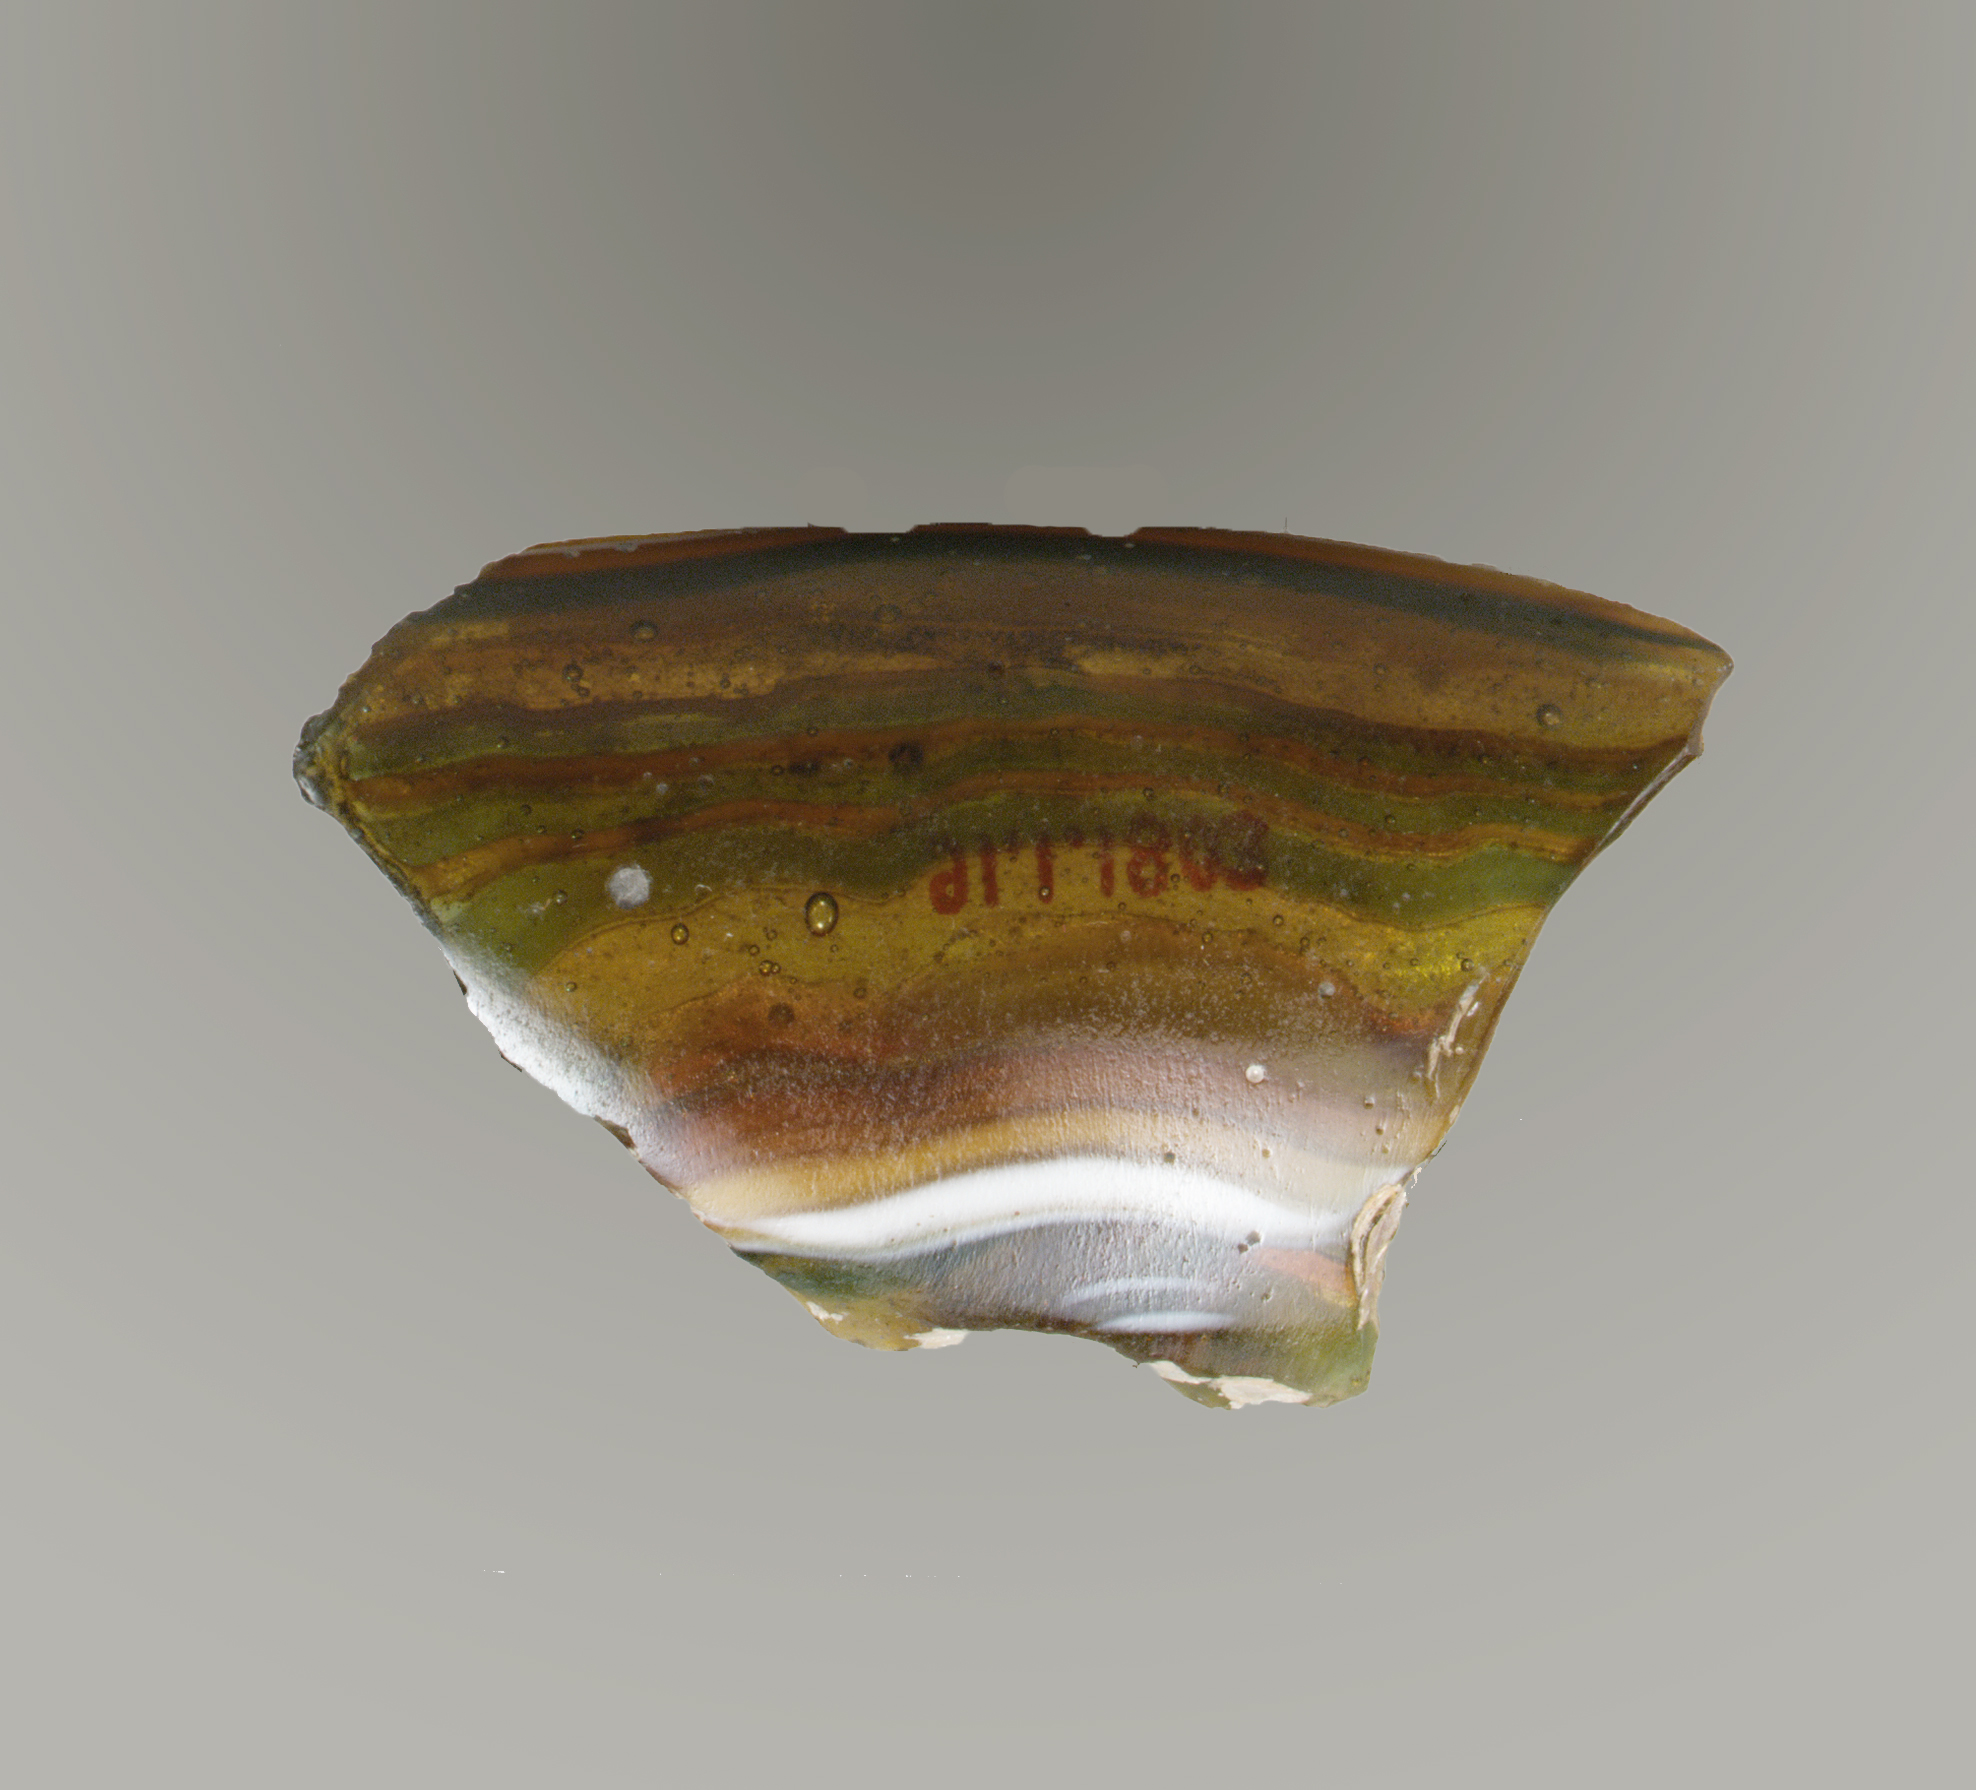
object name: fragment, mosaic bowl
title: Glass mosaic ribbed bowl fragment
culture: roman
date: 34 BCE-33 CE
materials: glass